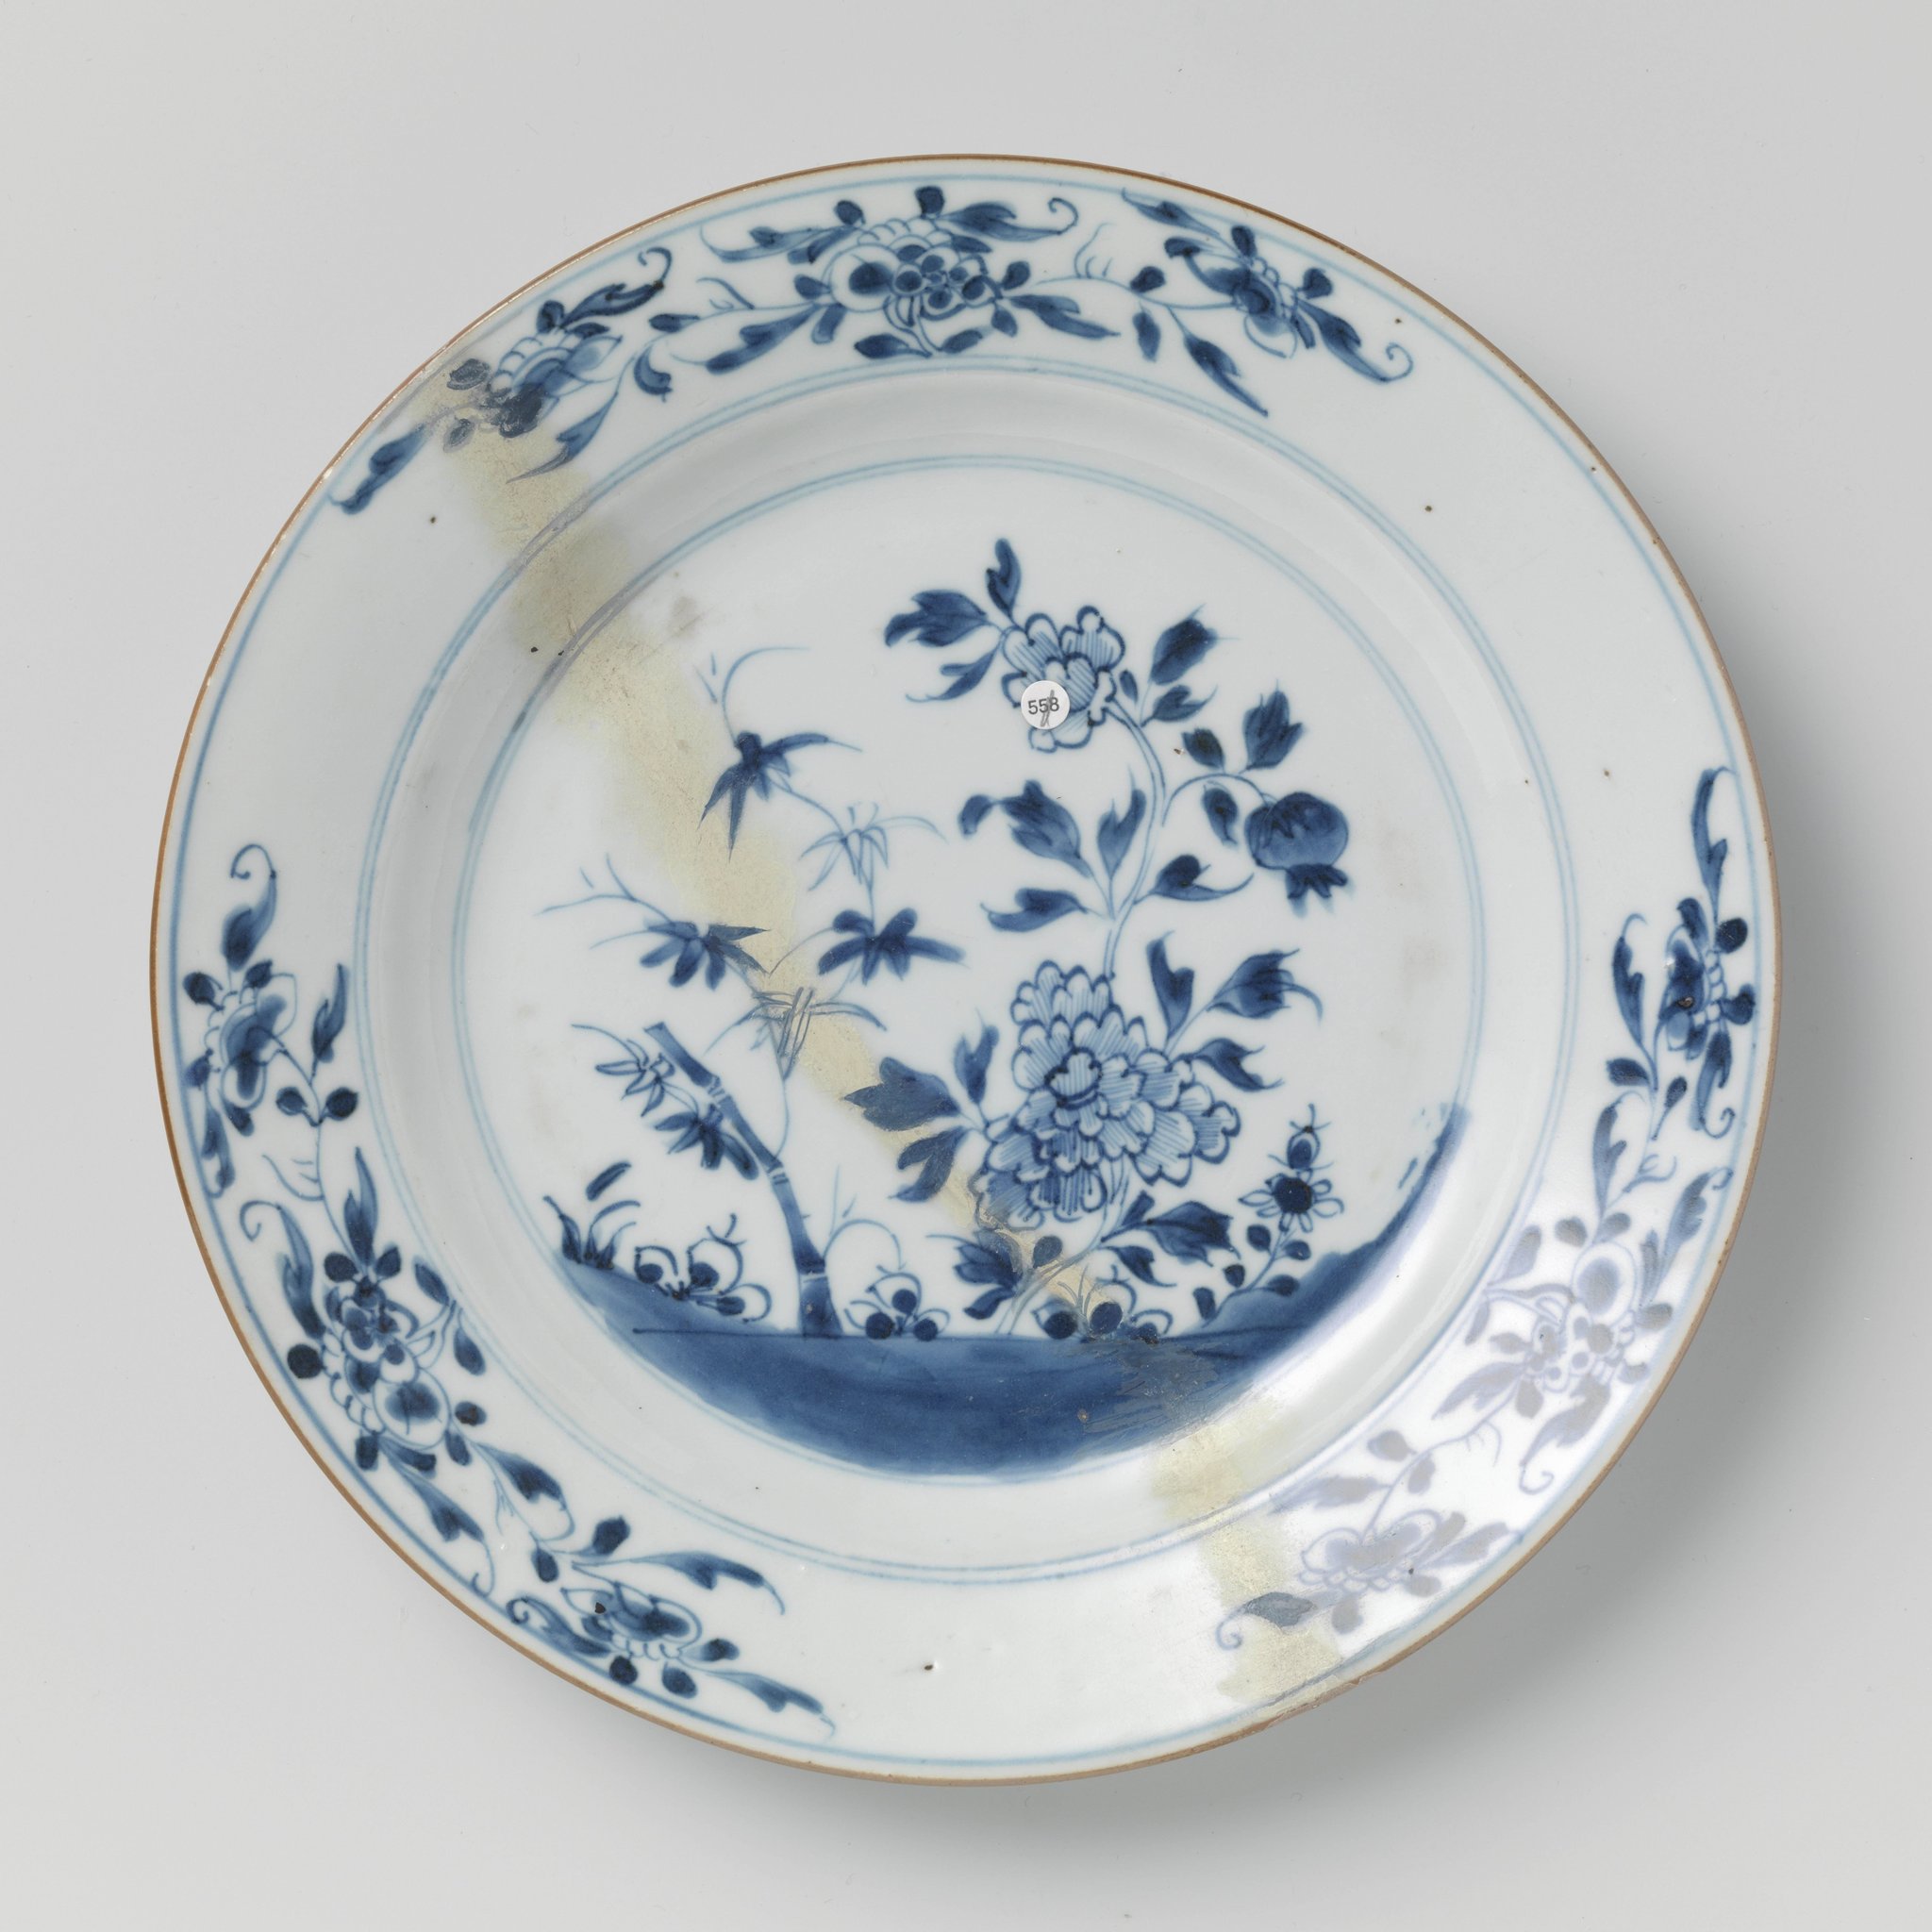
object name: plate dish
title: Plate with flowerting plants and bamboo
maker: Anonymous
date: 1725-1749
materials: cobalt, glaze, paint, porcelain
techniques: firing, turning, vitrification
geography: china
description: Bord van porselein met korte, ronde wand en schuine rand, beschilderd in onderglazuur blauw. Op het plat bloeiende bloemtakken (pioen), bamboe en planten; op de rand drie bloemtakken. Bord is gebroken geweest. Blauw-wit.